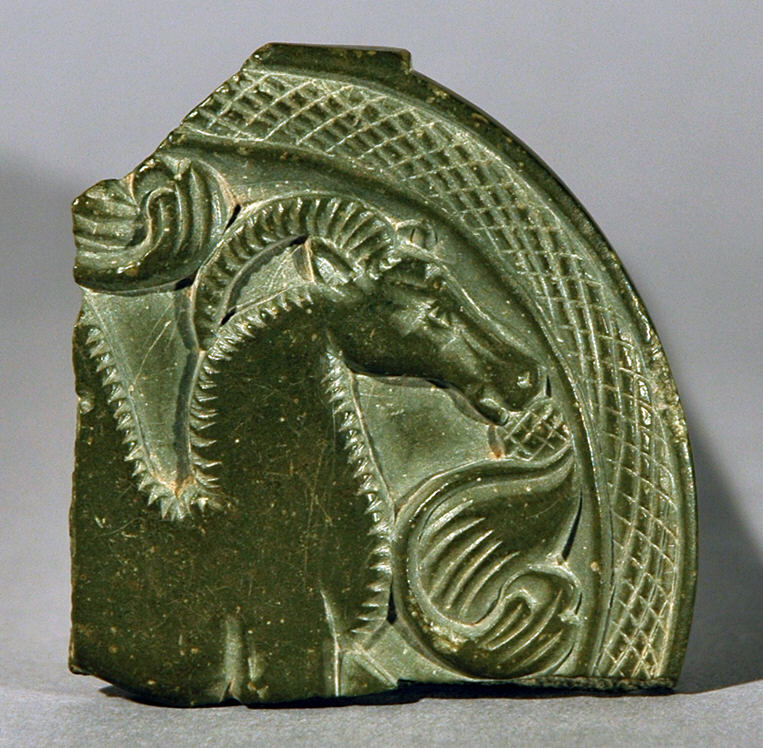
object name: box lid fragment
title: Fragment of a Box Lid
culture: gandhara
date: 401-500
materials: stone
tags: animals,gandhara